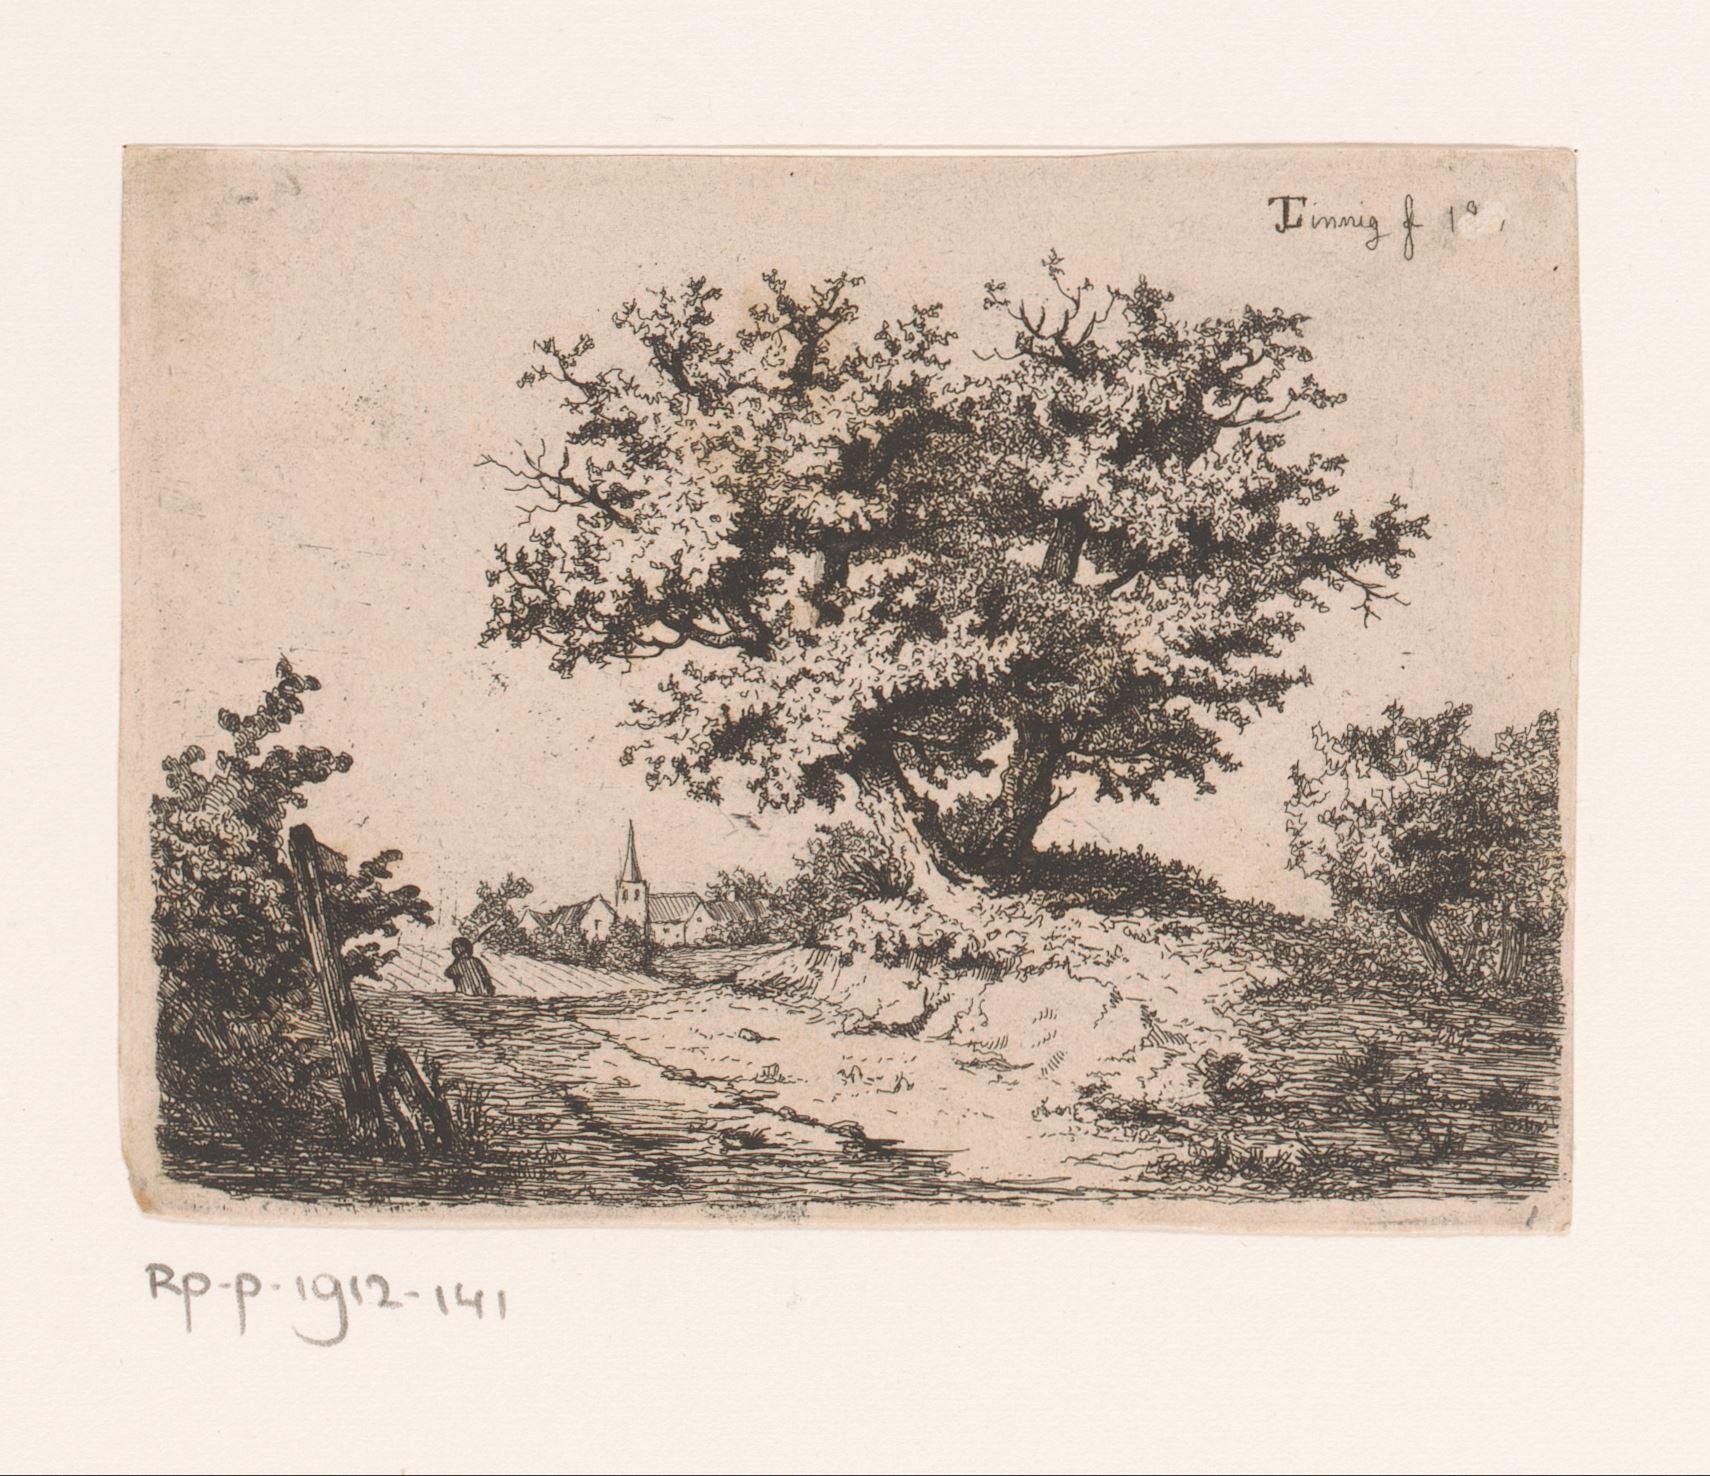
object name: print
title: Gezicht op de weg van Tervuren naar Duisburg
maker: jean théodore joseph linnig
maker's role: draughtsman, print maker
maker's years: 1815-1891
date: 1841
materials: paper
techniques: etching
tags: church (exterior), road, path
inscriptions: collector's mark: Lugt 1485, collector's mark: Lugt 2228